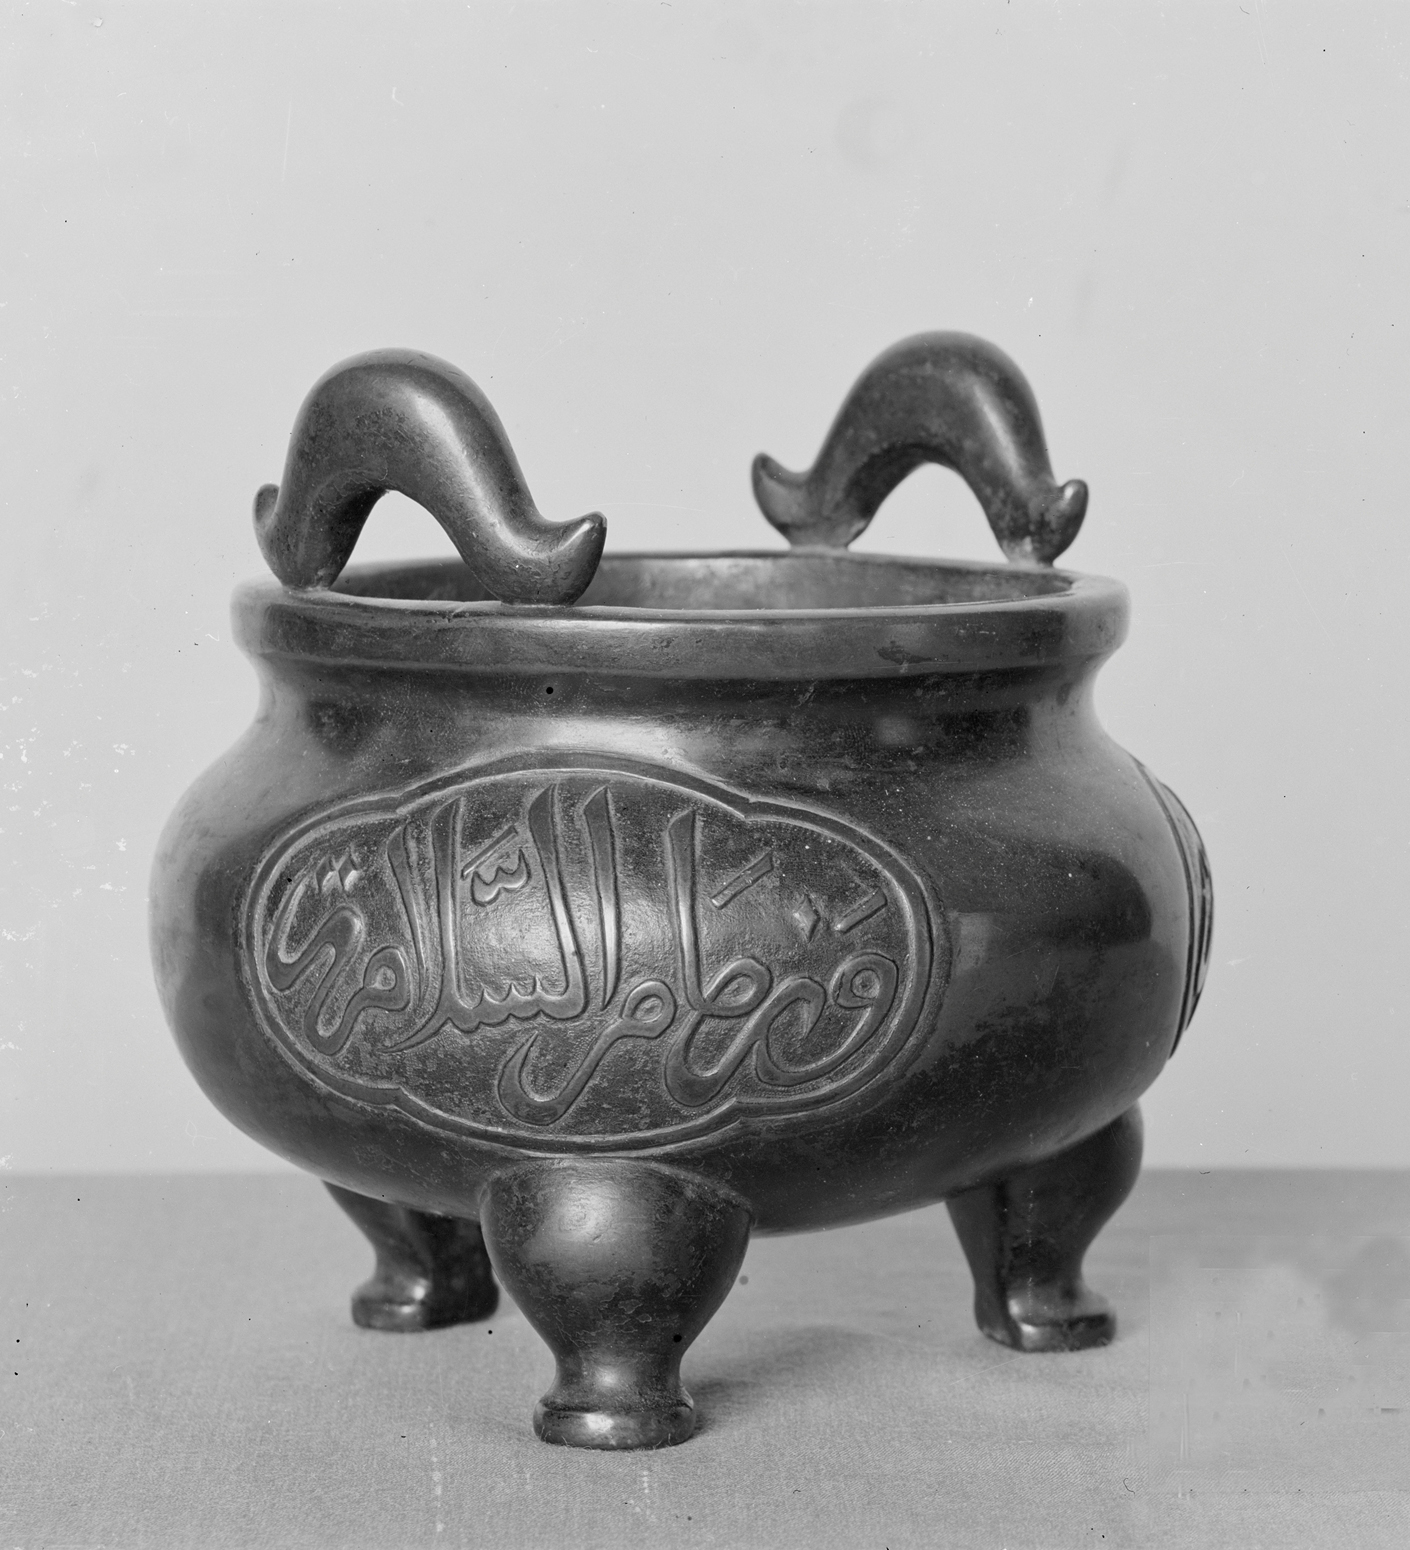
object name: incense burner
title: Incense burner with Arab inscription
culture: chinese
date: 1661-1722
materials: bronze